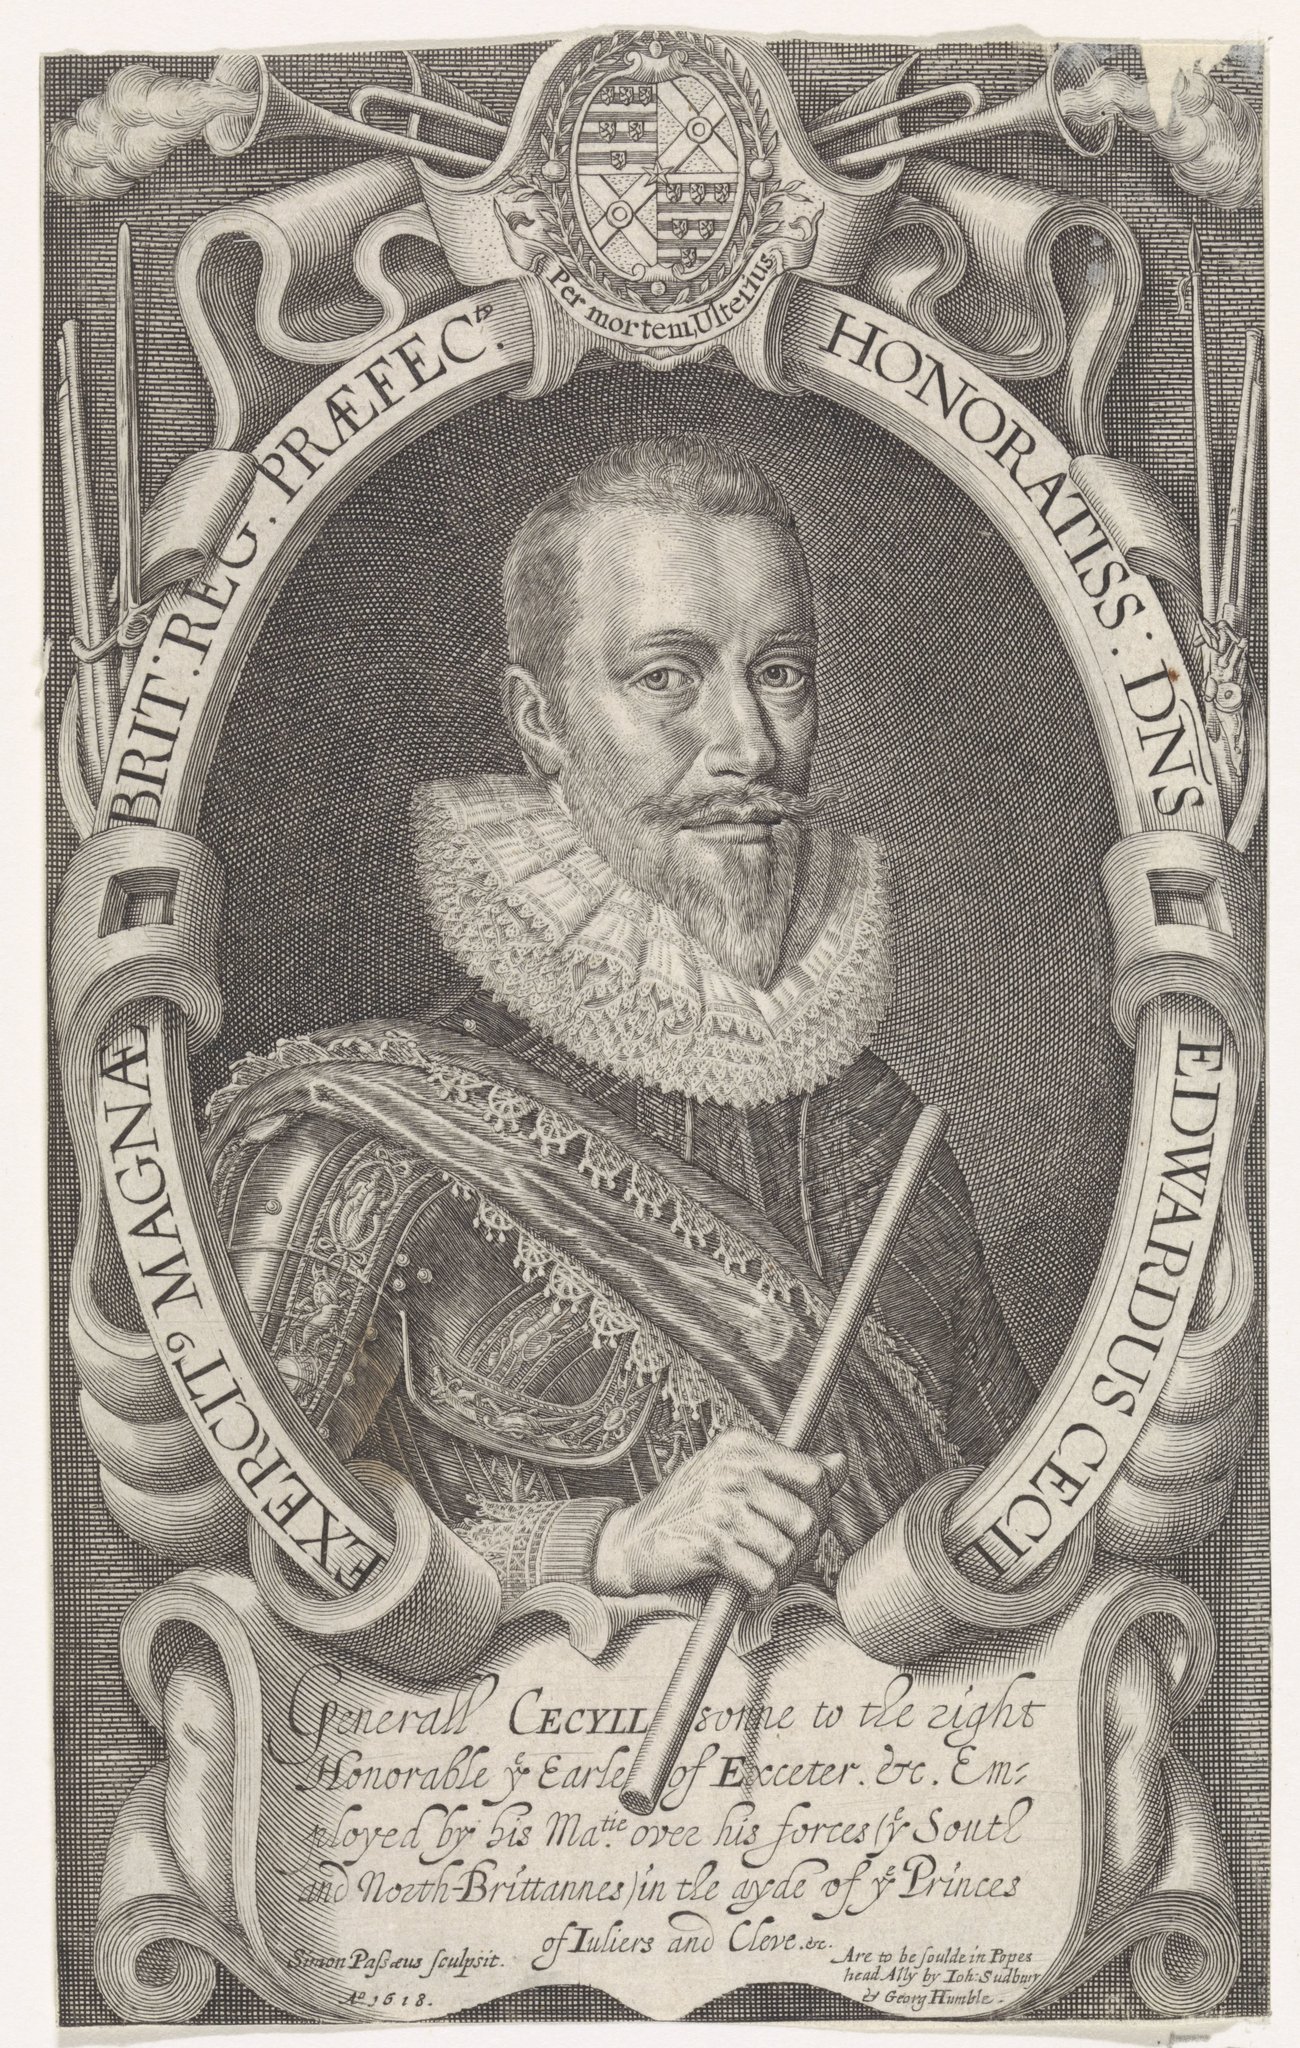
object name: print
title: Portret van Edward Cecil, burggraaf van Wimbledon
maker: simon van de passe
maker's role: print maker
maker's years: 1595-1647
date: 1618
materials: paper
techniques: engraving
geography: london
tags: casting weapons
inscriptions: collector's mark: Lugt 2228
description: Portret van de militair Edward Cecil, burggraaf van Wimbledon. In het randschrift van de omlijsting de naam en functie van de geportretteerde in het Latijn. Boven de omlijsting het wapenschild van de geportretteerde en een motto in het Latijn. Rondom de omlijsting diverse wapens. Op de cartouche onder de omlijsting een vijfregelig onderschrift met de naam en functie van de geportretteerde in het Engels.